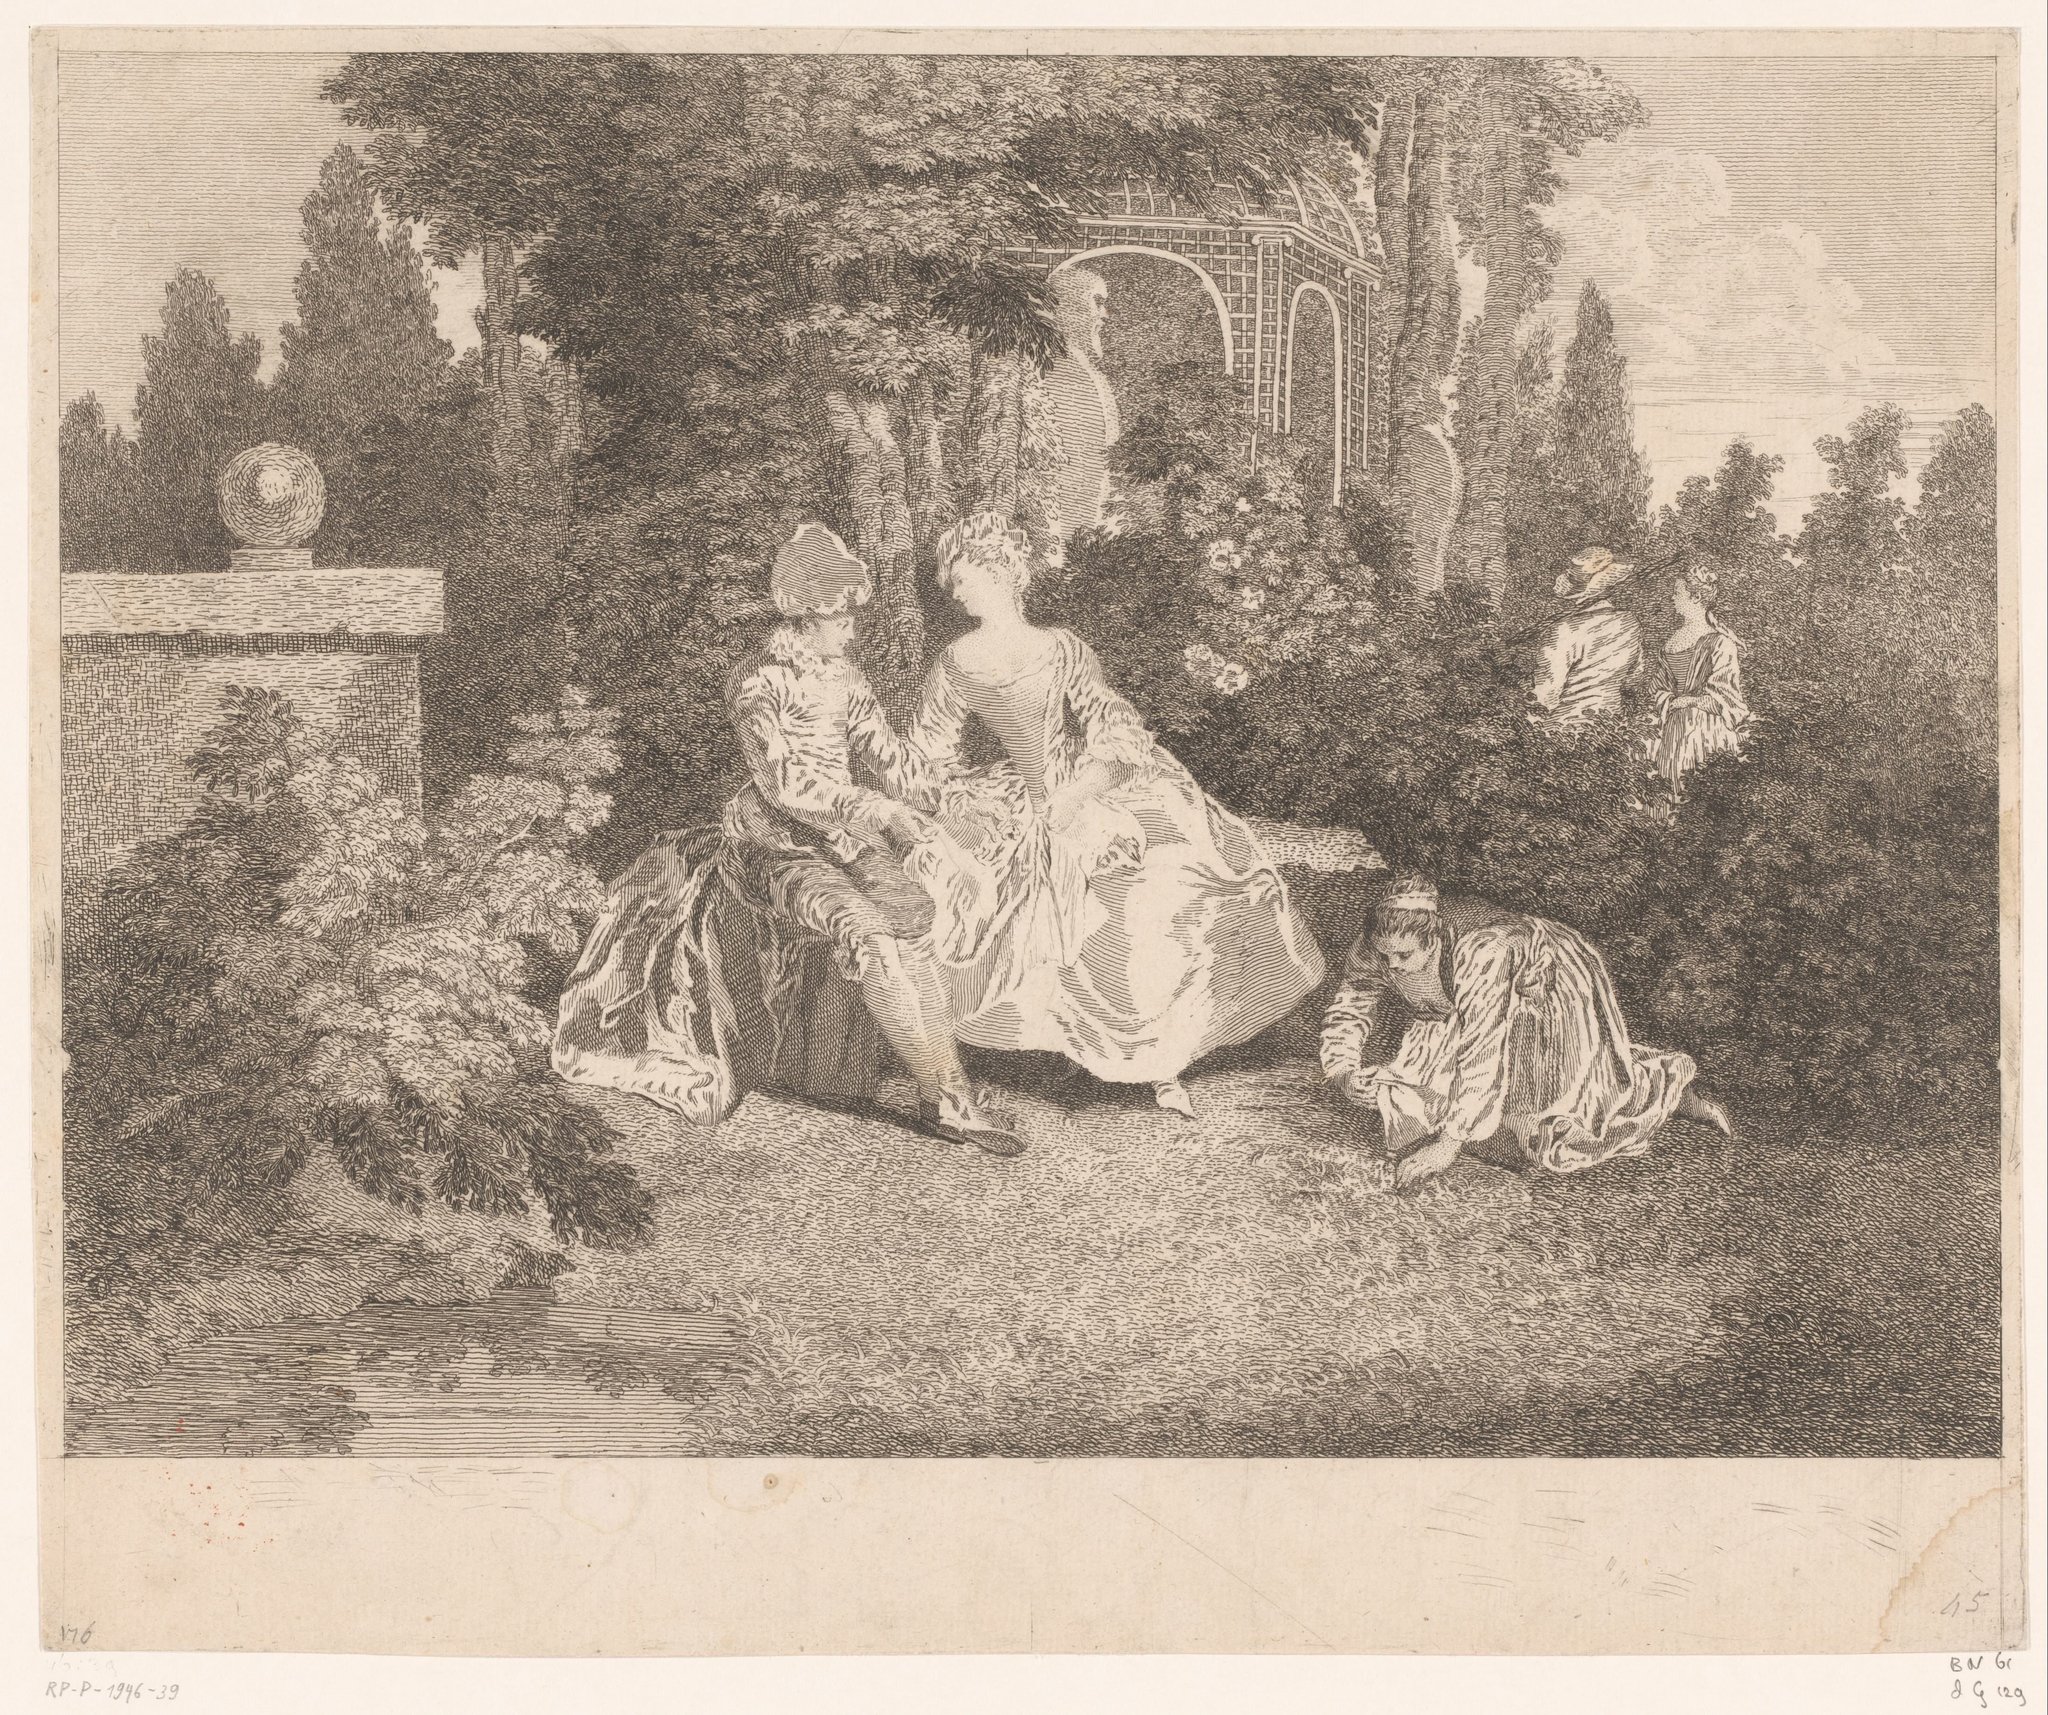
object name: print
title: Galant gezelschap in een tuin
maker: pierre alexandre aveline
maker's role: print maker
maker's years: 1702-1760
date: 1712-1760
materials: paper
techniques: etching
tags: summer-house, arbour, garden-house (dutch: 'theekoepel'), statues, sculptures in garden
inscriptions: collector's mark: Lugt 240, collector's mark: Lugt 2228